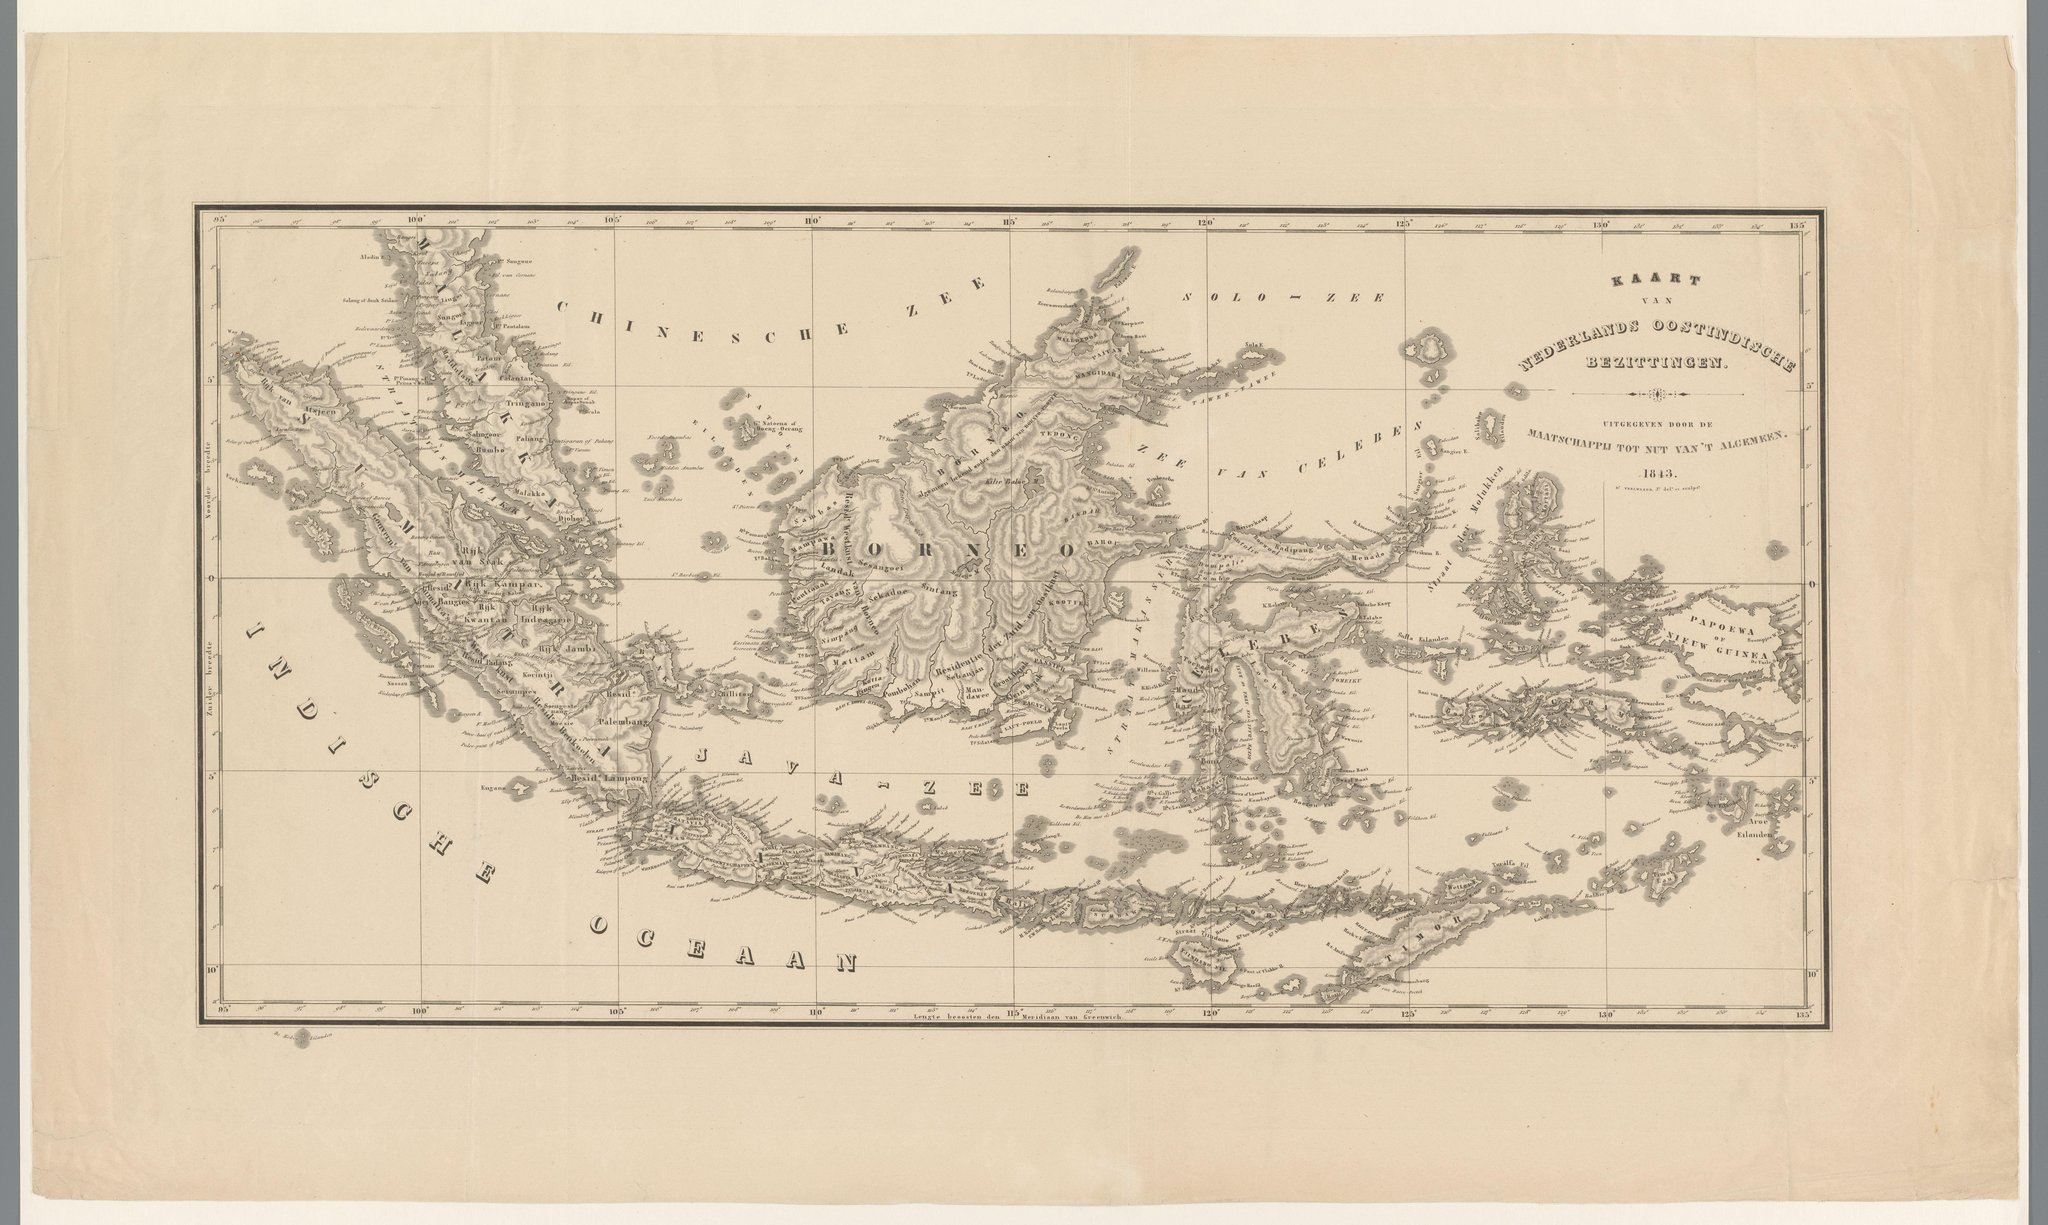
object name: print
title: Kaart van Nederlands Oostindische bezittingen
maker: daniël veelwaard (ii)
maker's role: print maker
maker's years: 1796-1868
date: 1843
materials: paper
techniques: engraving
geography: amsterdam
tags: maps of separate countries or regions, dutch east indies, the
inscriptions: collector's mark: Lugt 2228